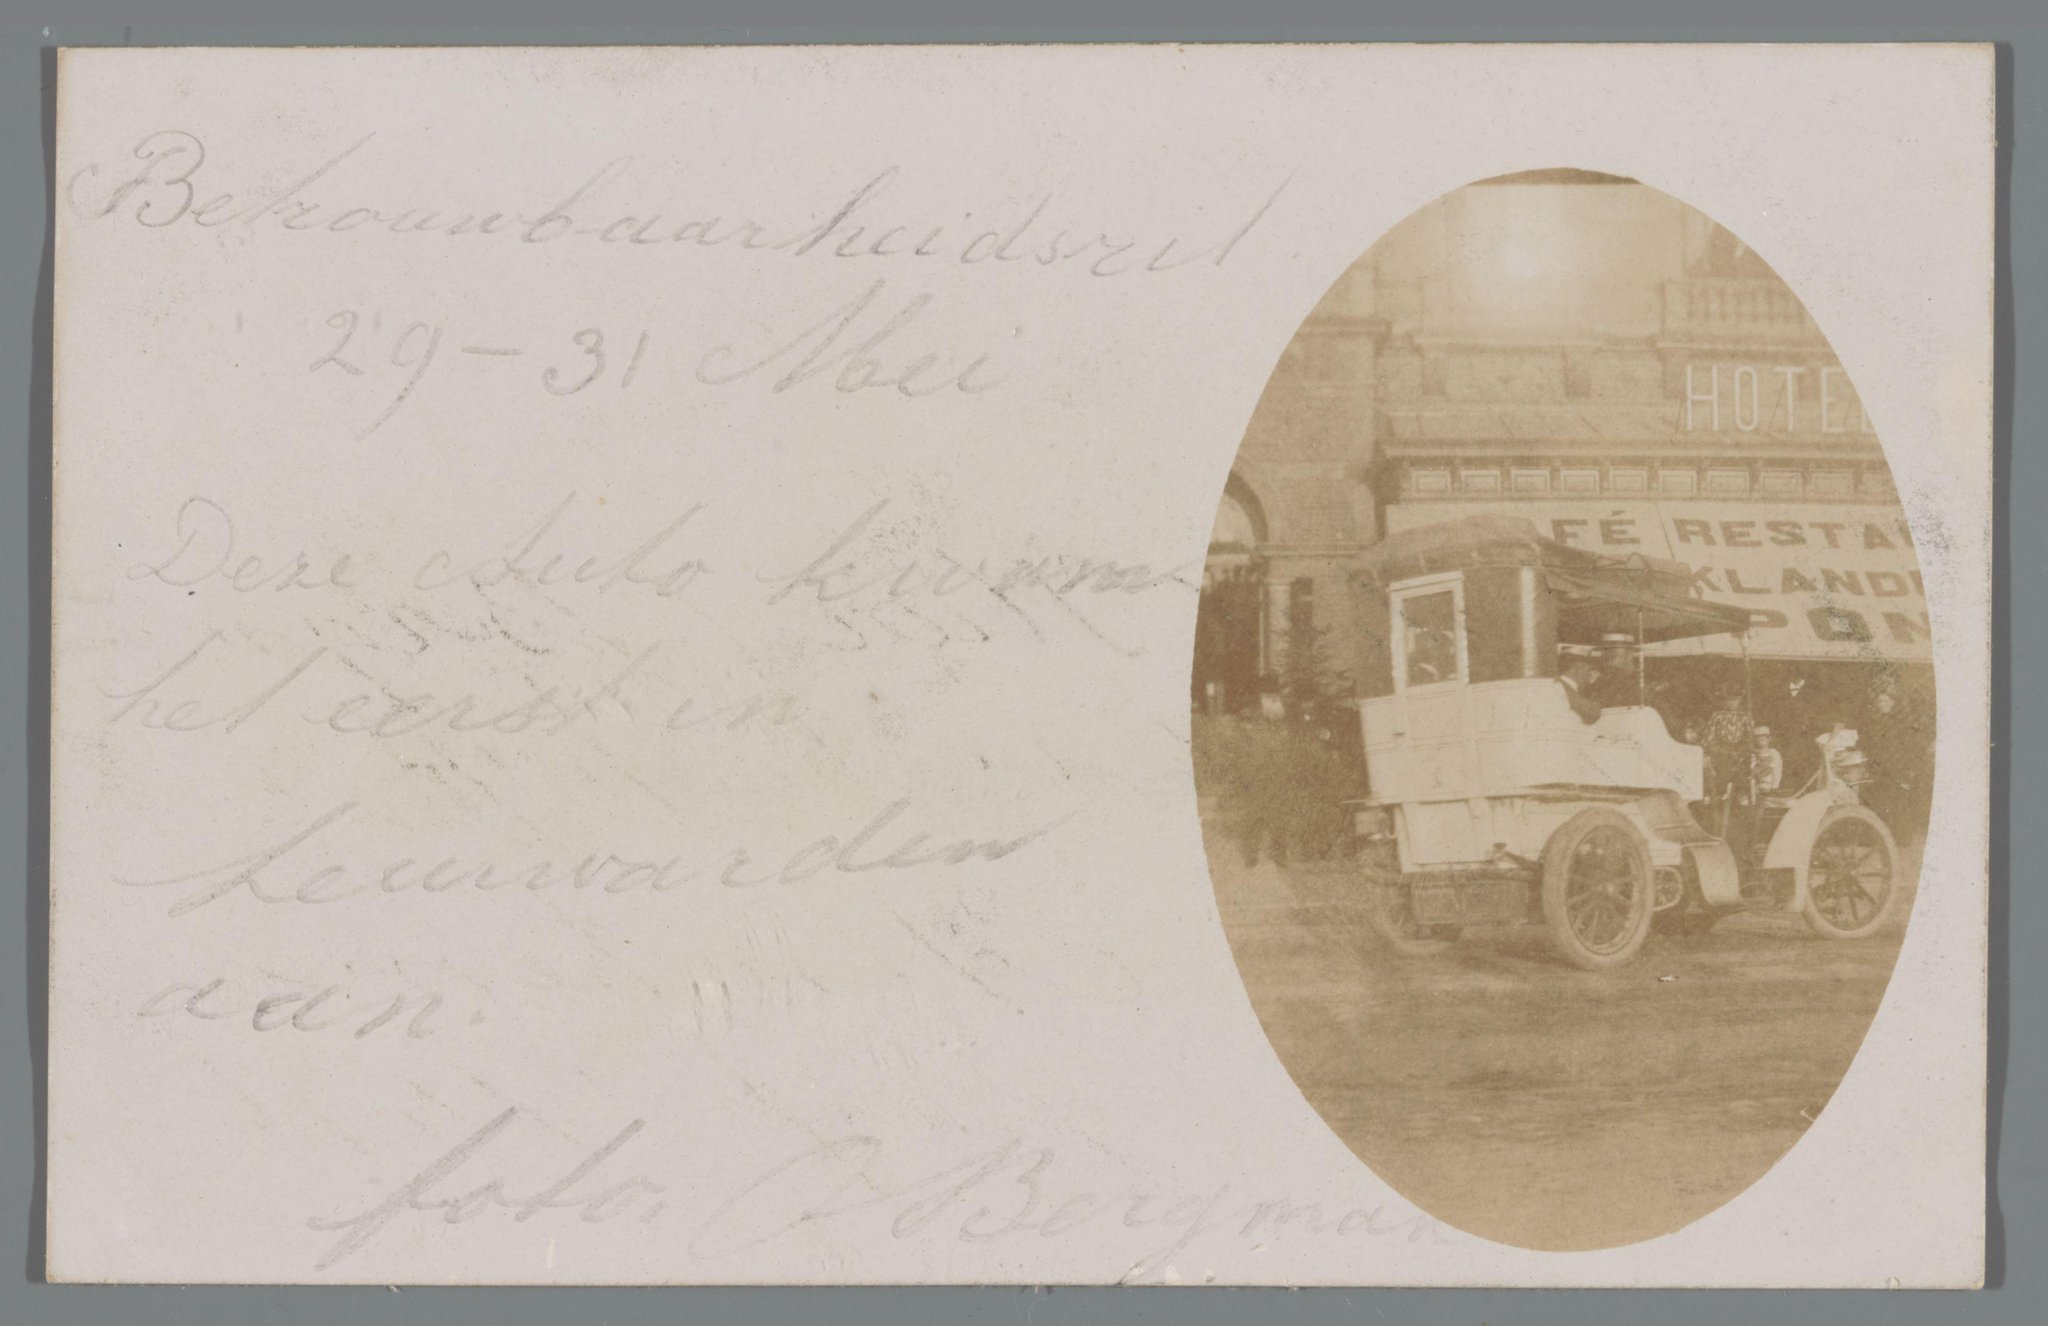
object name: photograph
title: Aankomst van de eerste auto in Leeuwarden na een autorace van 29 tot 31 mei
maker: o. bergman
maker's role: amateurfotograaf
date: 1895-1905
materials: paper, pencil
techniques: gelatin silver print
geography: leeuwarden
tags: chariot, triumphal car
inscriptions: address: ‘Aan den WelE Heer O Bergman/ p/a Mevr. Wedu Verhoeff/ Arnhem/ Graaf Ottoplein/ 17’, inscription: ‘Betrouwbaarheidsrit/ 29-31 Mei/ Deze Auto kwam/ het eerst in/ Leeuwarden/ aan./ foto. O. Bergman’